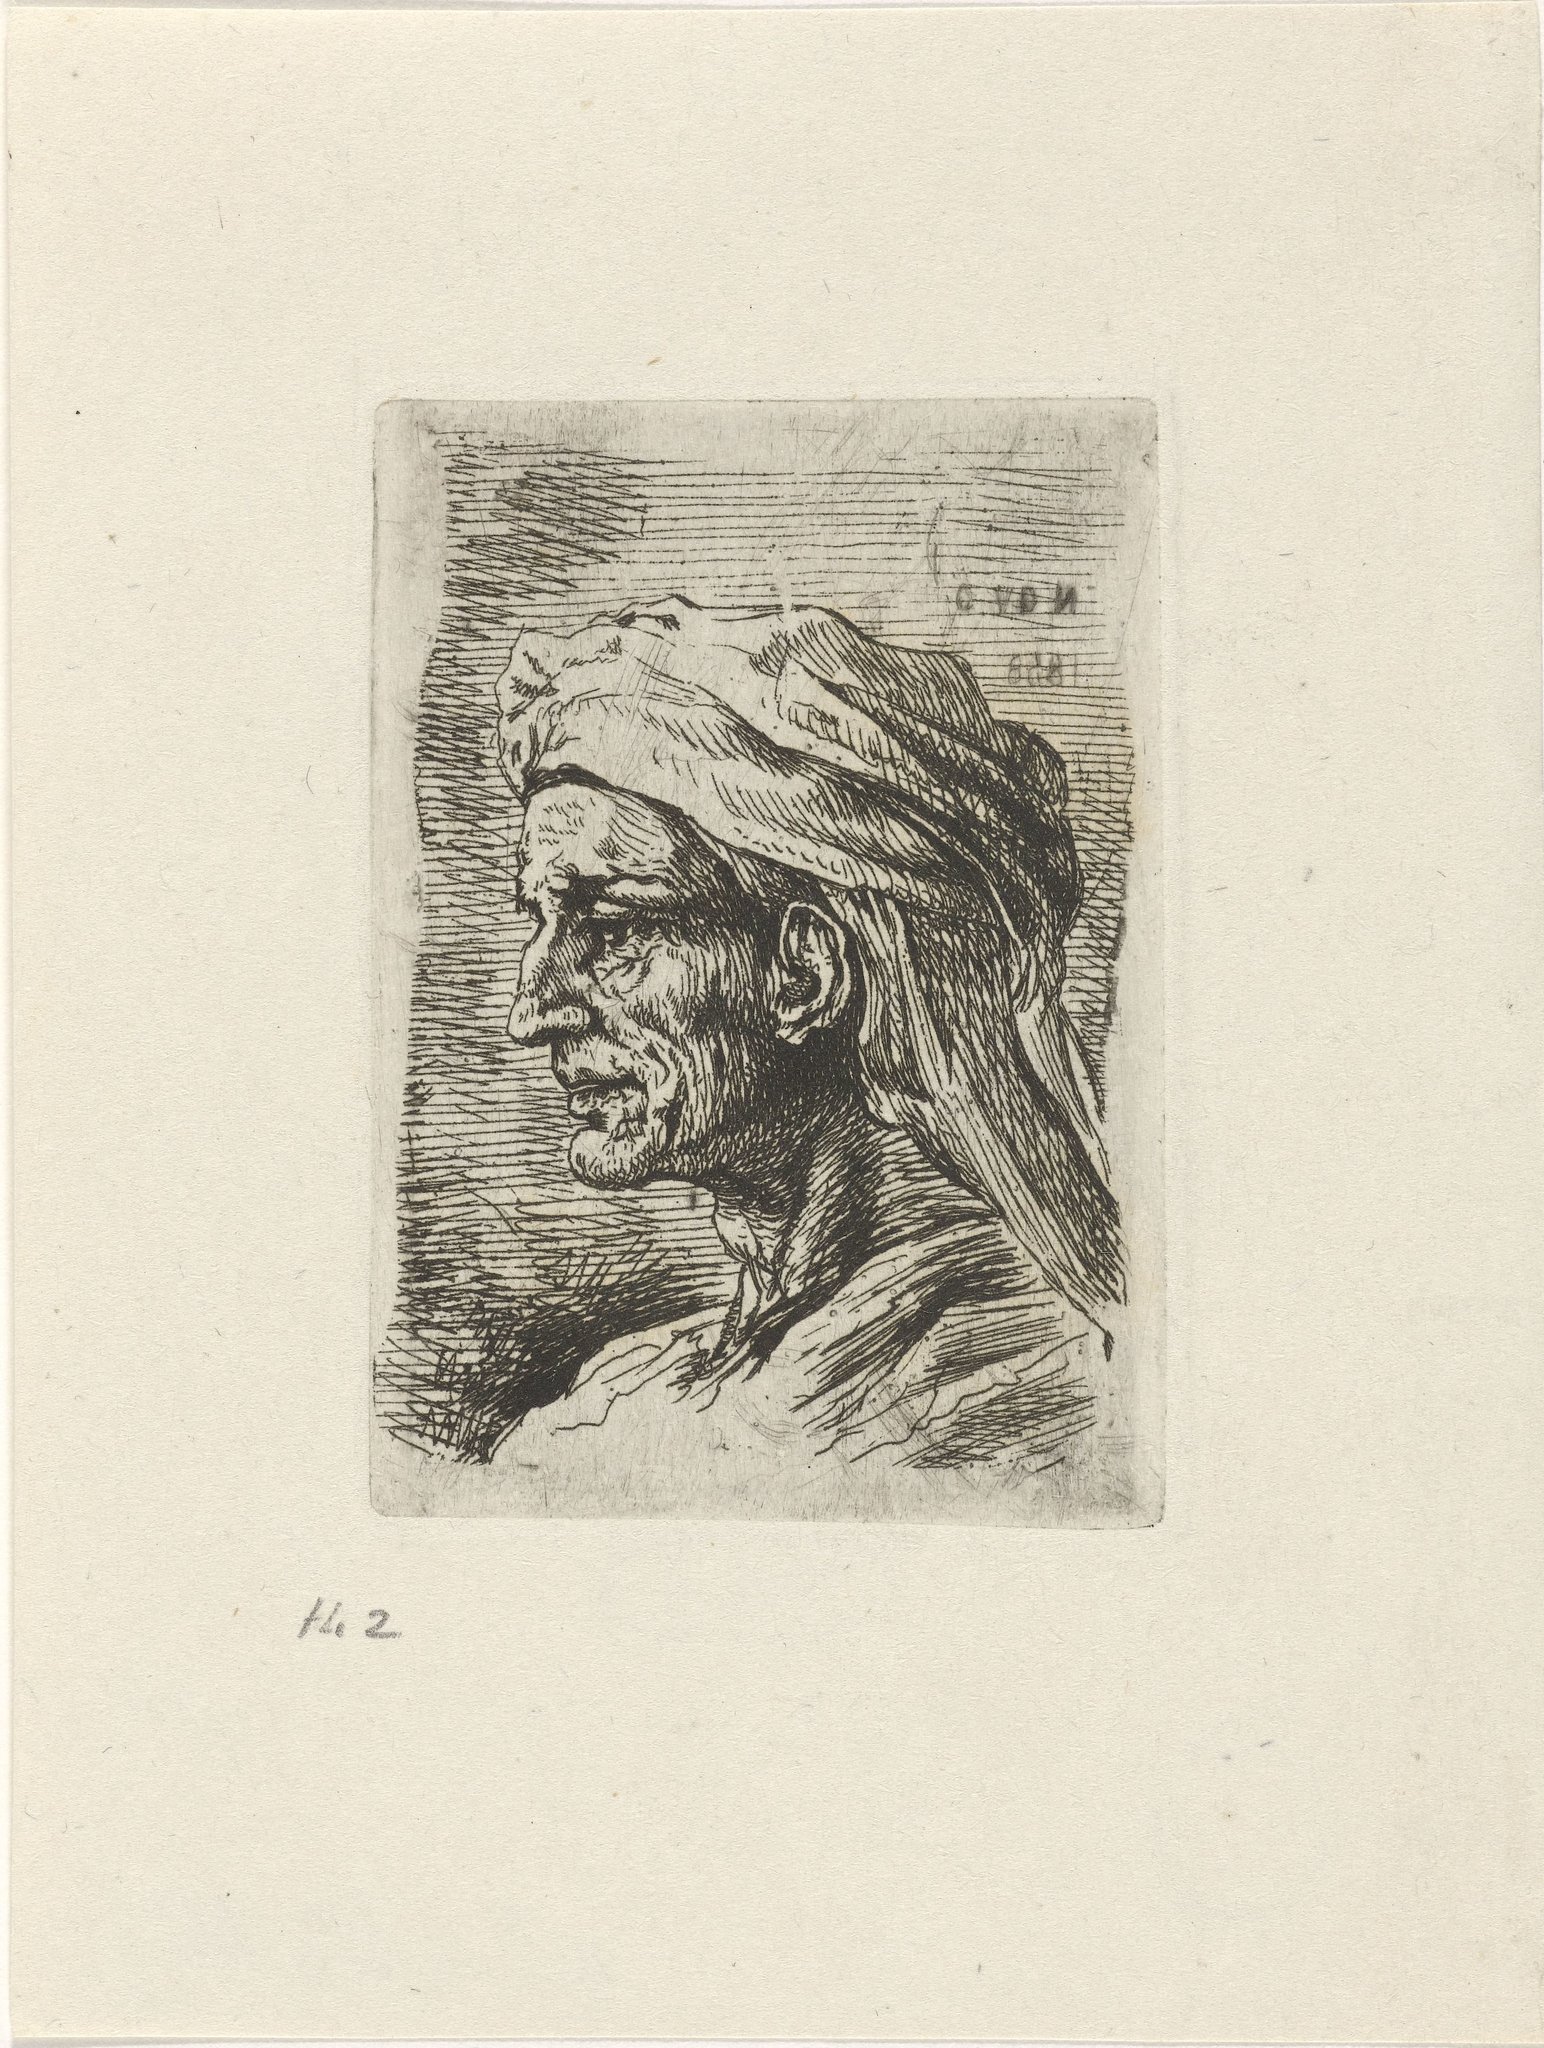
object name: print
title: Portret van een man met een tulband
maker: cornelis justinus geisweit van der netten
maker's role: print maker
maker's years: 1842-1875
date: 1858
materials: paper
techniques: etching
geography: netherlands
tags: head-gear: turban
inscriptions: collector's mark: Lugt 2228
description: Een man met een tulband op zijn hoofd. Buste en profil naar links.